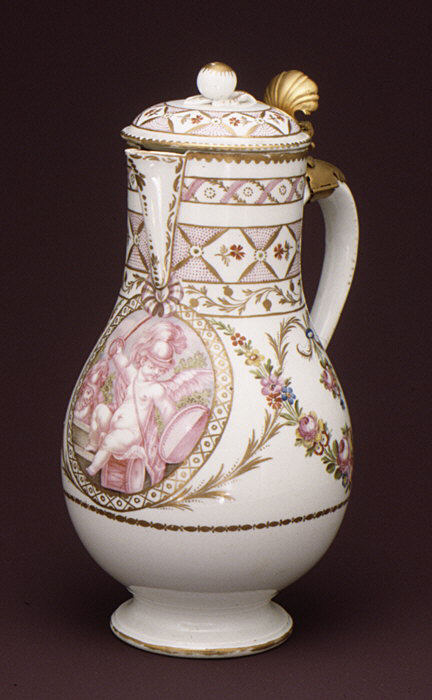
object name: ewer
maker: la courtille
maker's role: factory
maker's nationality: french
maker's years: 1771-1840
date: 1775-1780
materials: hard paste porcelain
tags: cupid,flowers